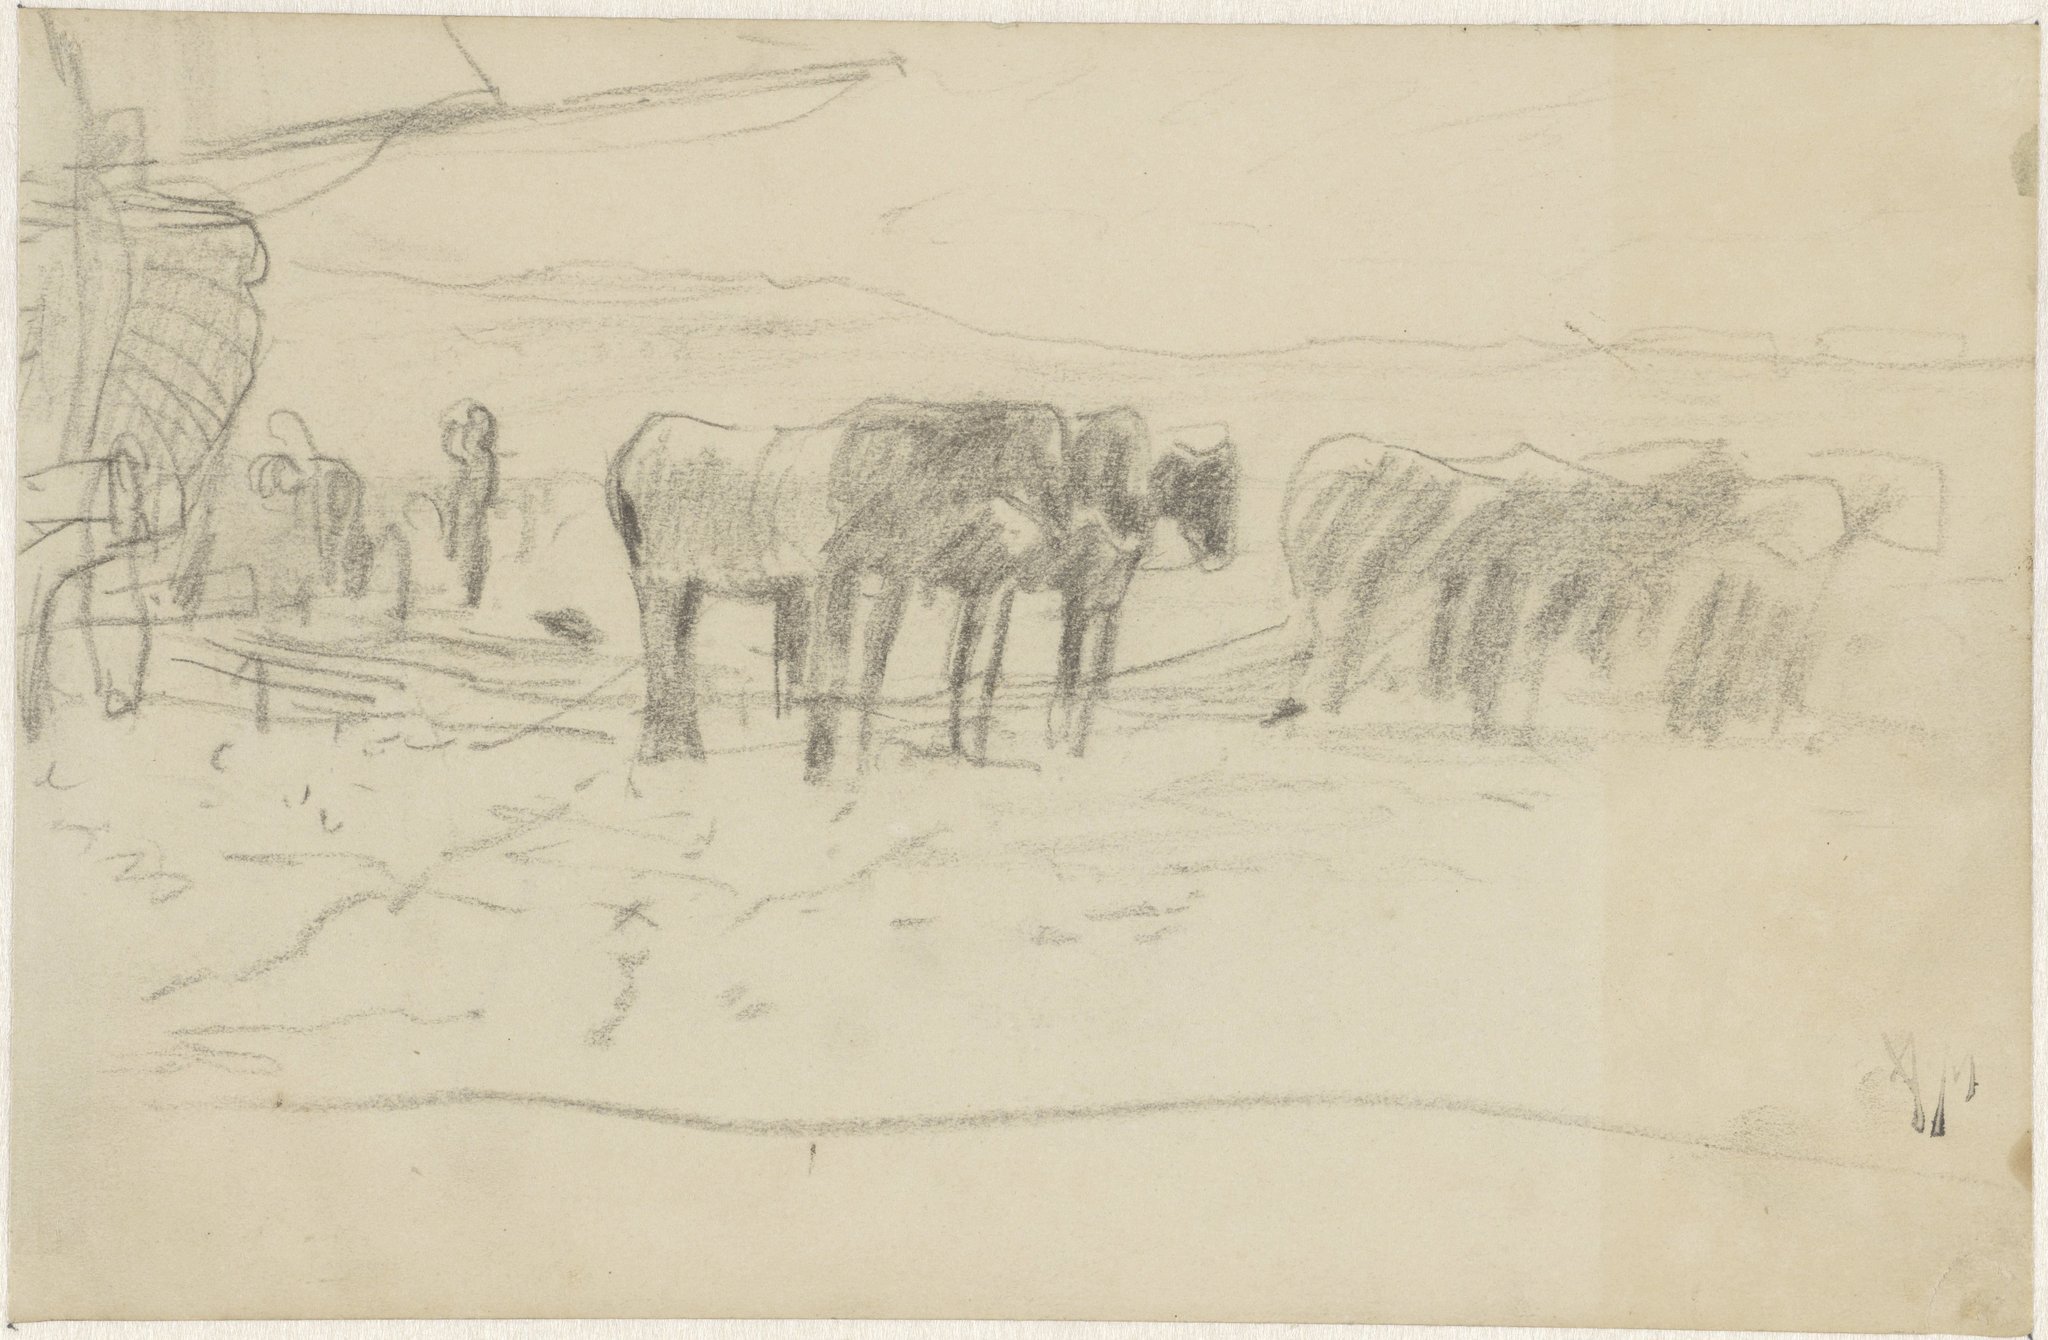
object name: drawing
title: Paarden voor een schuit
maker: anton mauve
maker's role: draughtsman, painter, print maker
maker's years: 1838-1888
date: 1848-1888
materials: chalk, paper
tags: sailing-ship, sailing-boat, horse